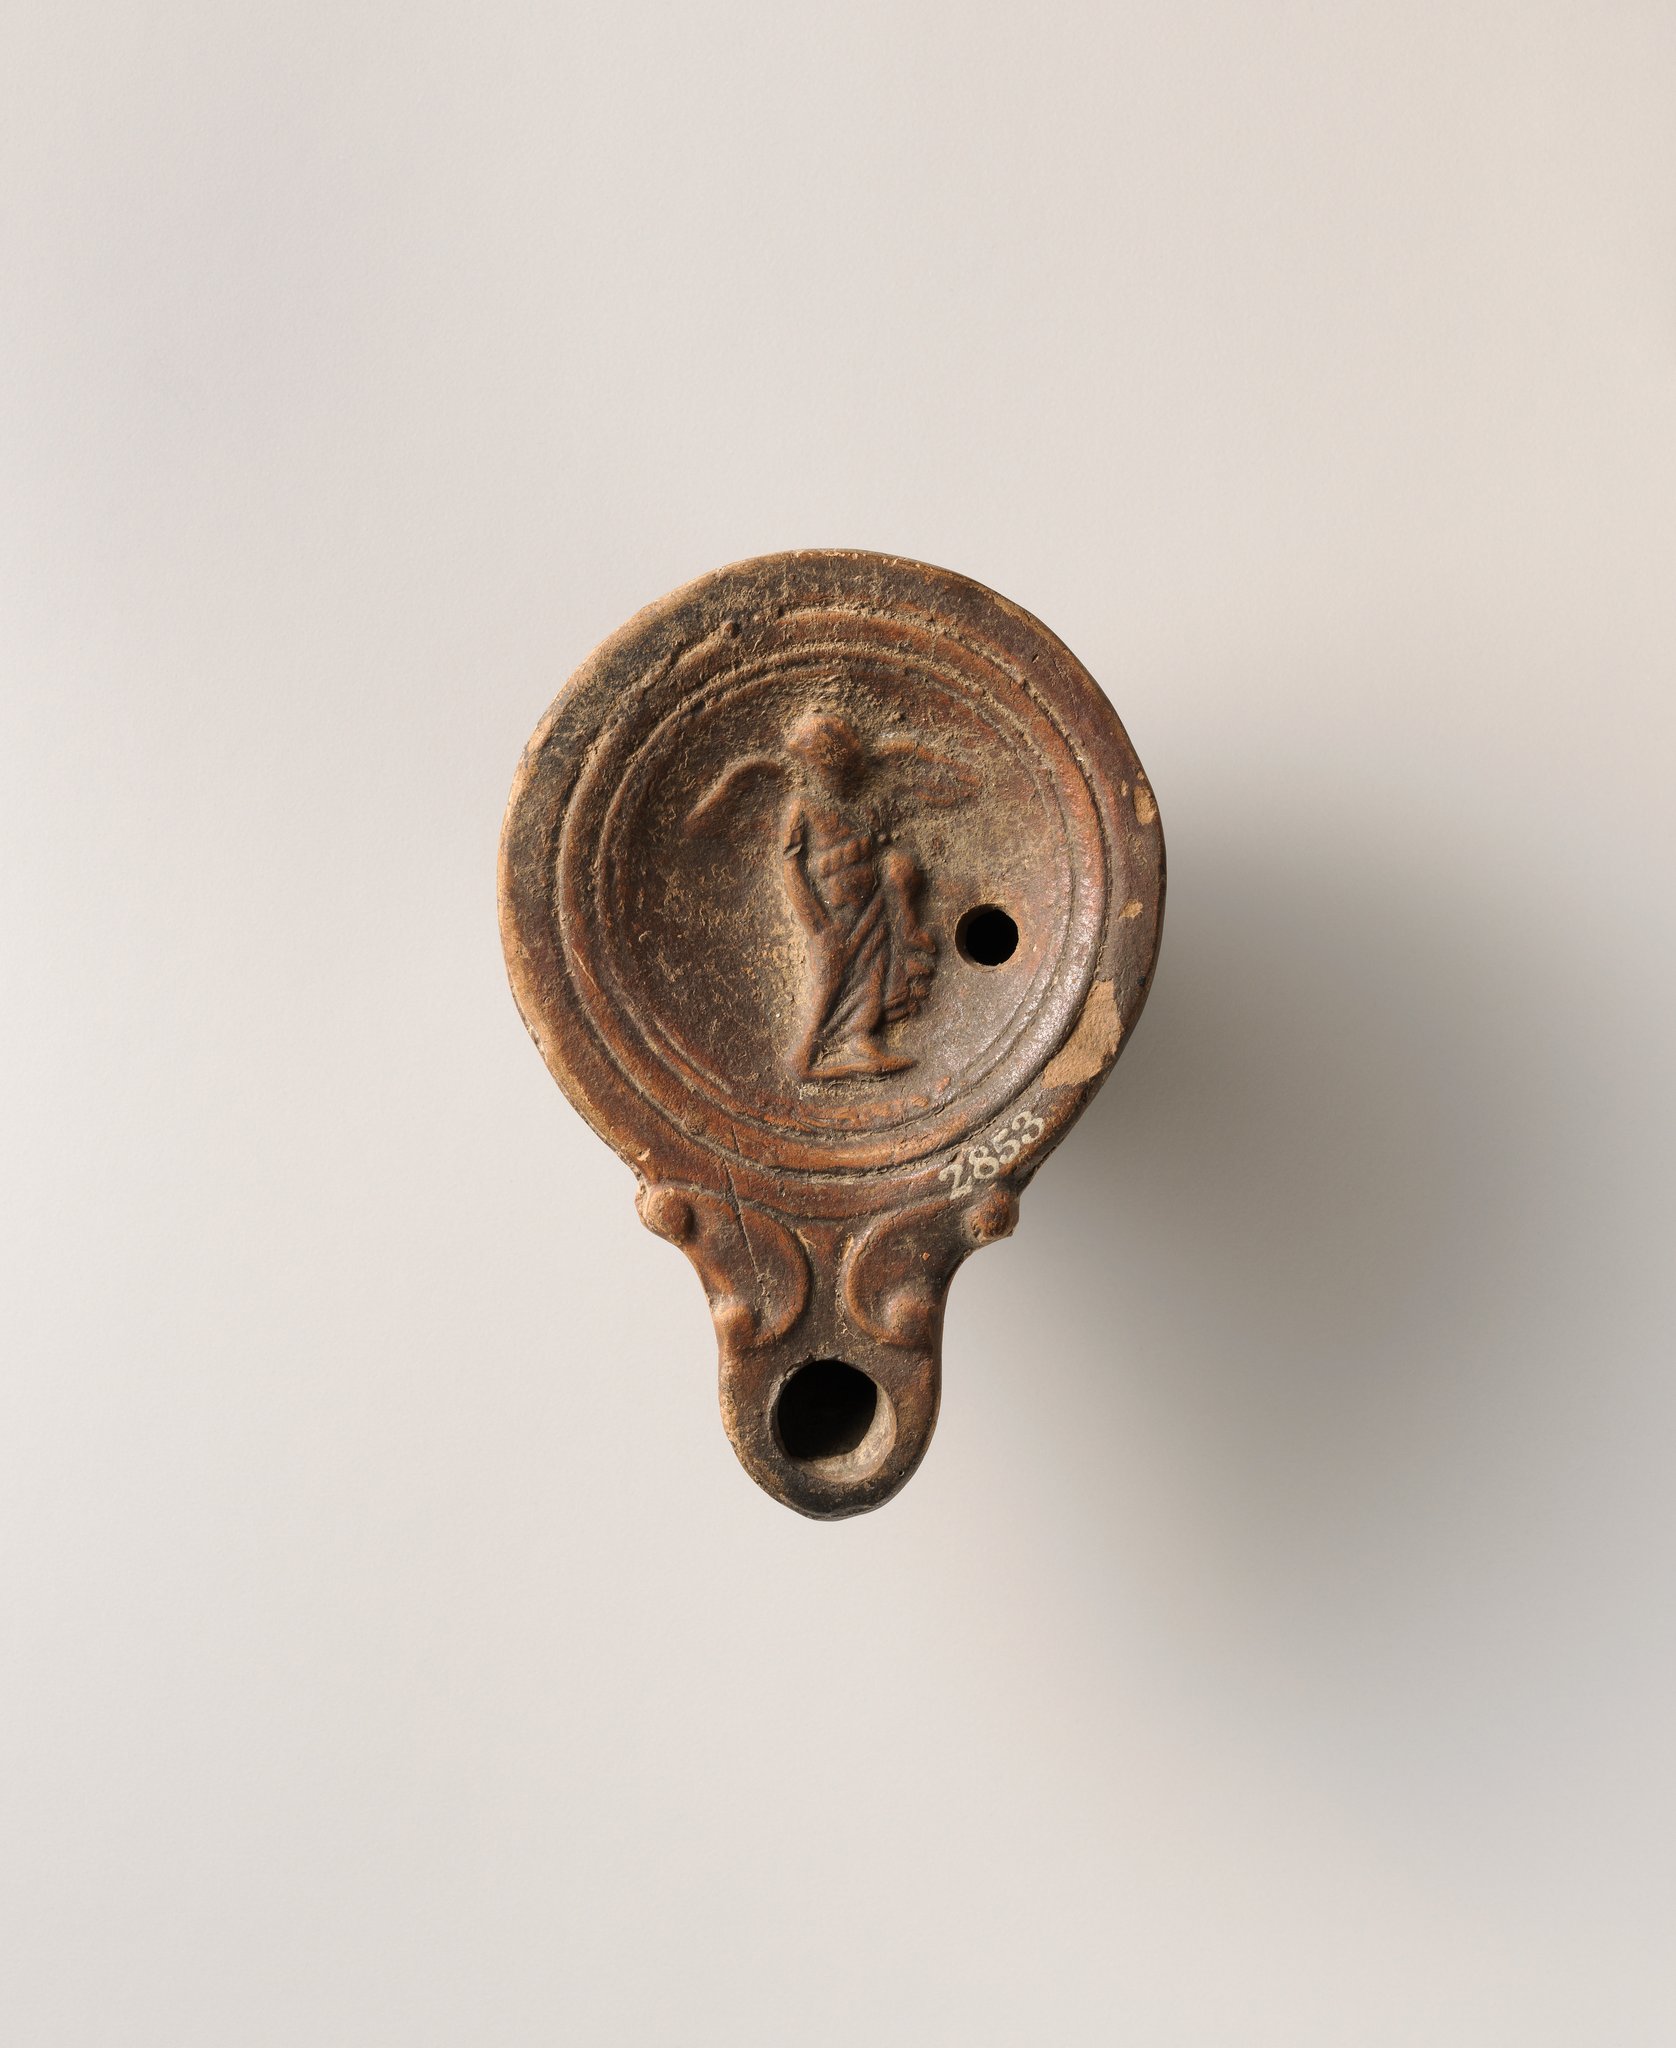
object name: lamp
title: Terracotta oil lamp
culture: roman, cypriot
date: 40-100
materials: terracotta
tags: eros